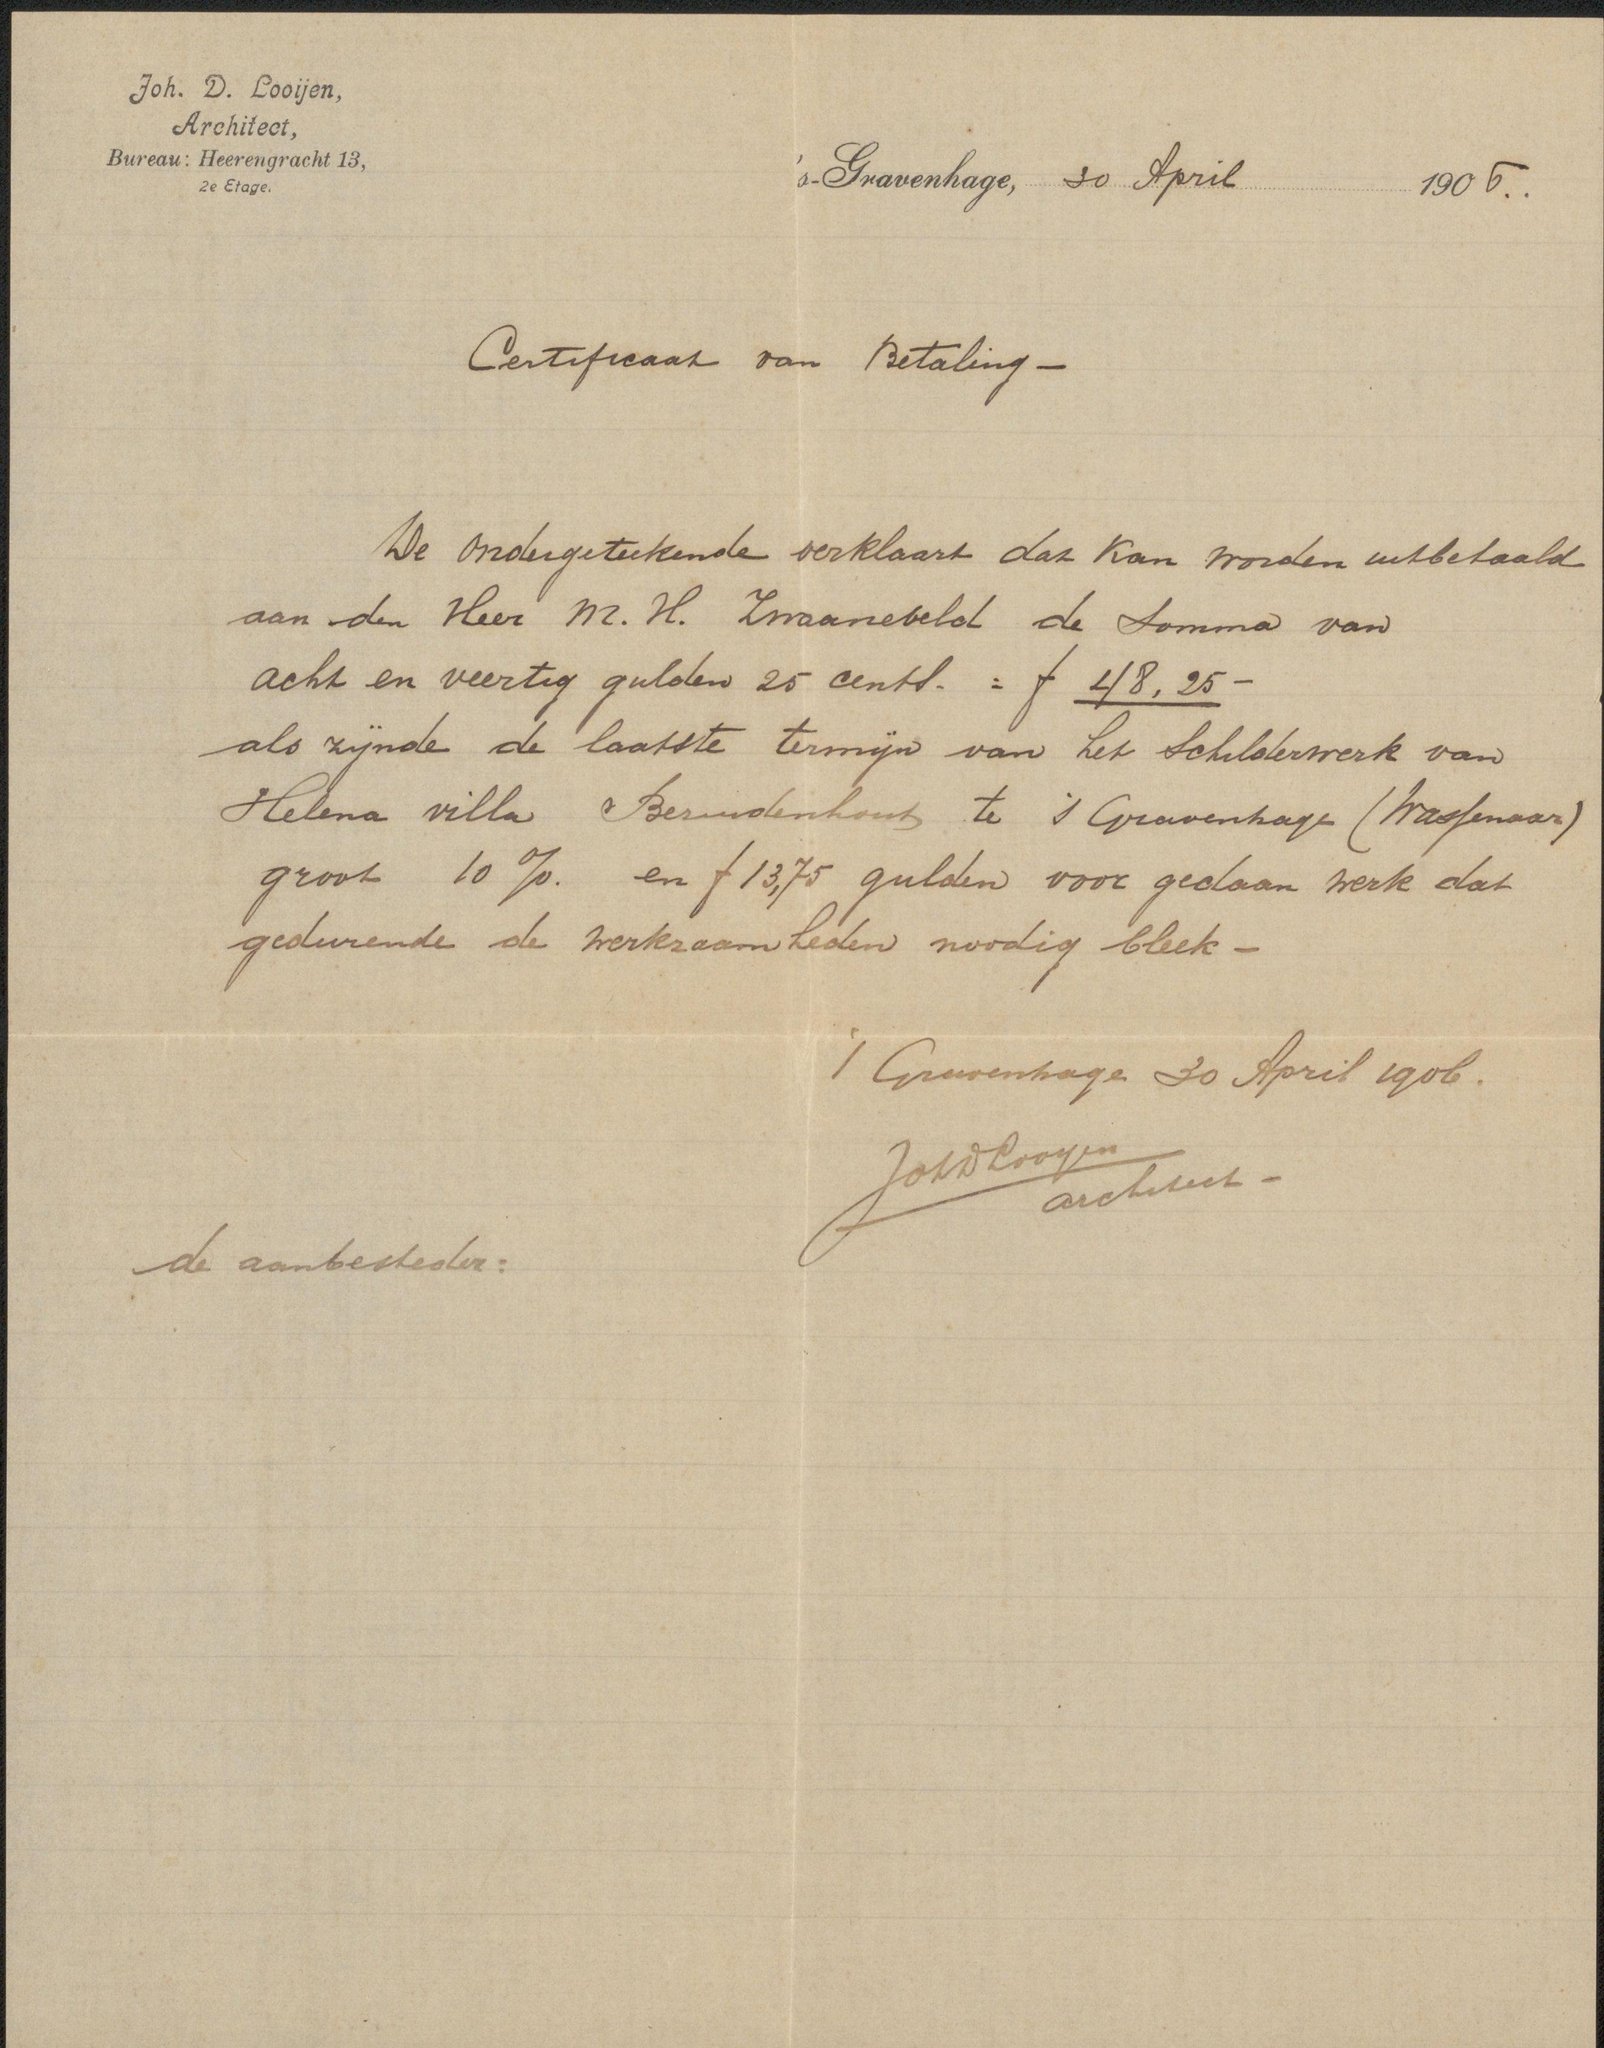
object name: letter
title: Brief aan Philip Zilcken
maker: johan dionysius looyen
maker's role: draughtsman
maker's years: 1876-1944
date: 1906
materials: ink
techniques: pen, printing, writing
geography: the hague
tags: the hague, painter, philip zilcken, money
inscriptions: collector's mark: ‘RPK’